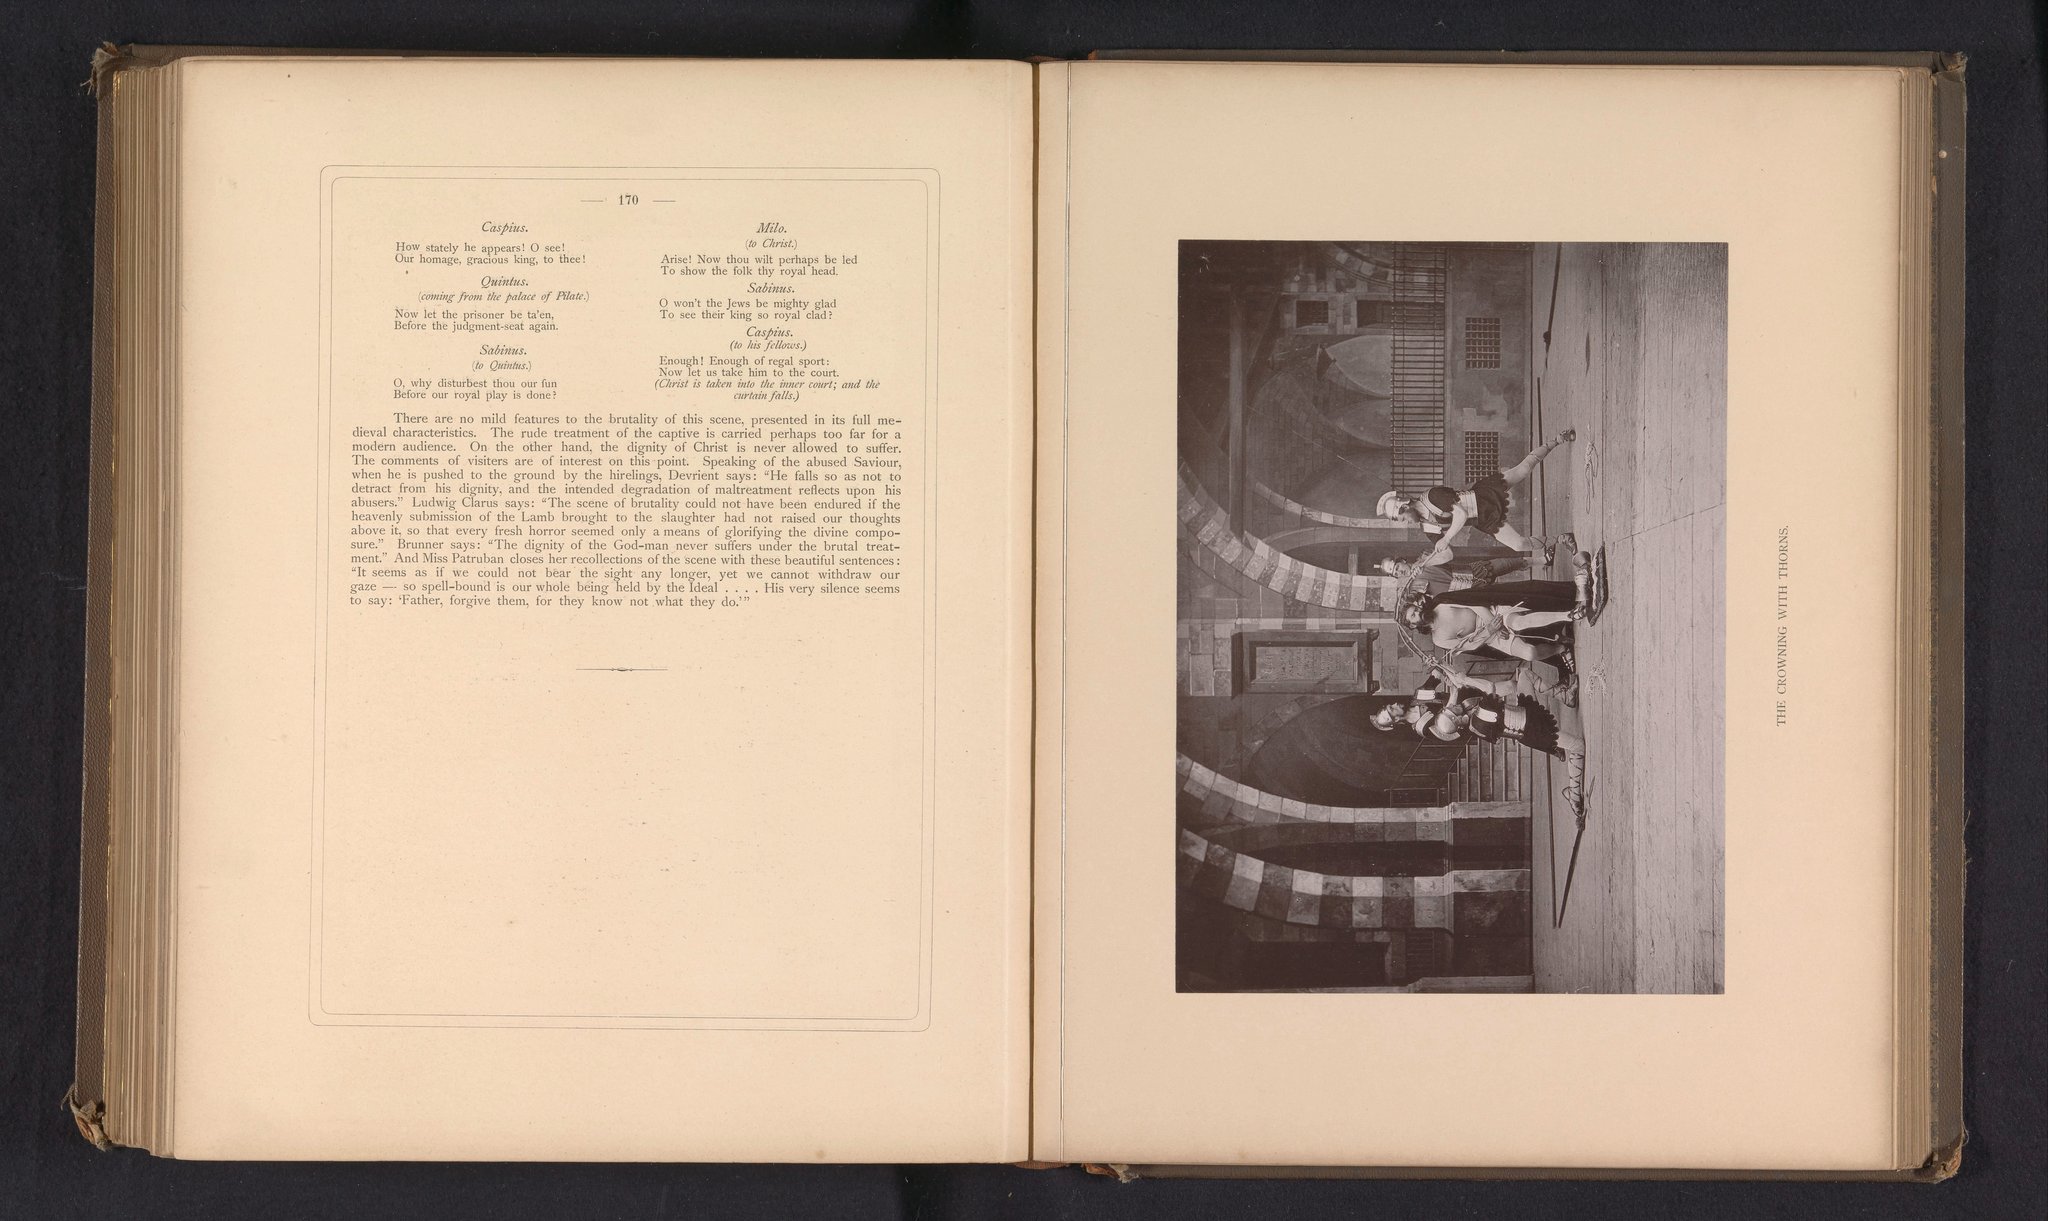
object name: page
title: The crowning with thorns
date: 1885-1890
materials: paper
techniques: photograph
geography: oberammergau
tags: group of actors, troupe; actors on the stage, the crowning with thorns: soldiers with sticks place a thorny crown on christ's head and give him a reed (matthew 27:27-31; mark 15:16-20; john 19:2-3)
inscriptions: inscription: ‘Gemeinde Oberammergau Passionsspiel 1890’